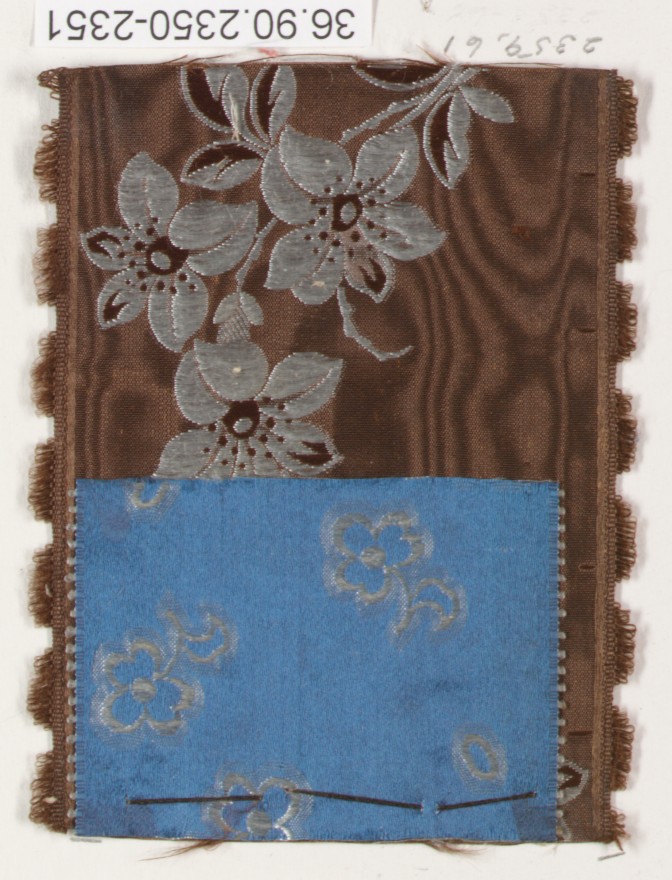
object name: ribbon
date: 1801-1900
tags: flowers